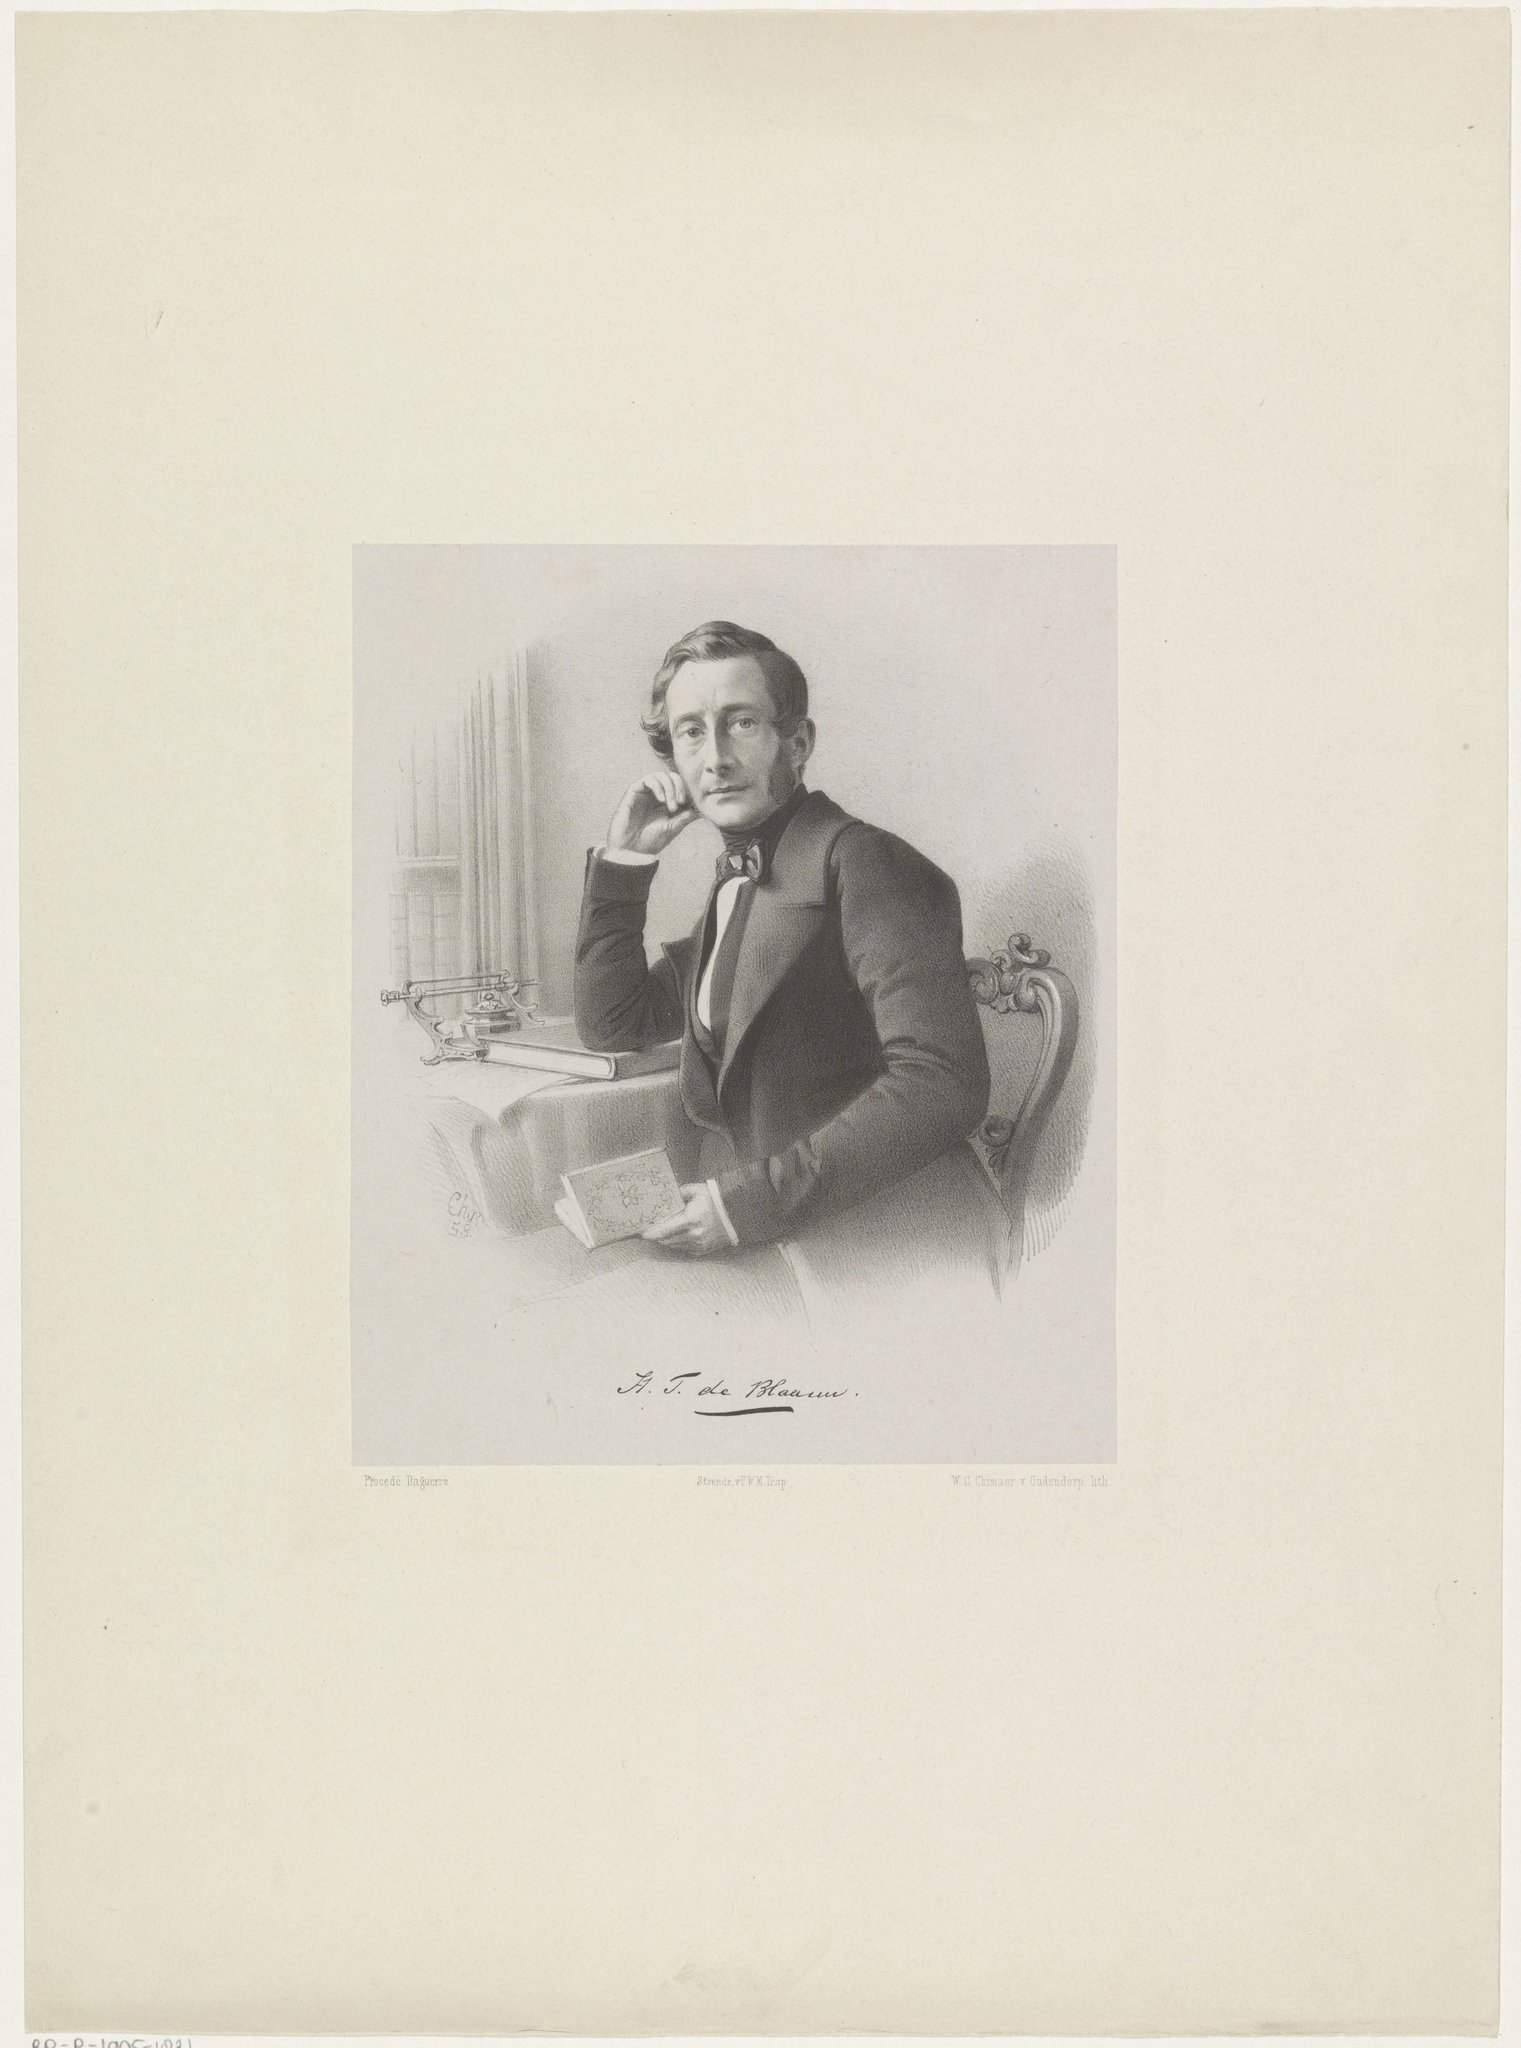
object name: print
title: Portret van H. T. de Blaauw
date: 1858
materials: paper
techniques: lithograph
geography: leiden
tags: bookshelves, book, historical persons (+ (full) bust portrait)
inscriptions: collector's mark: Lugt 2228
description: De geportretteerde zit aan een tafel en steunt met zijn rechter elleboog op een boek. In zijn linkerhand heeft hij een opengeslagen boek. Op de tafel staat een inktstel en daarachter een boekenkast. Onder het portret zijn signatuur.